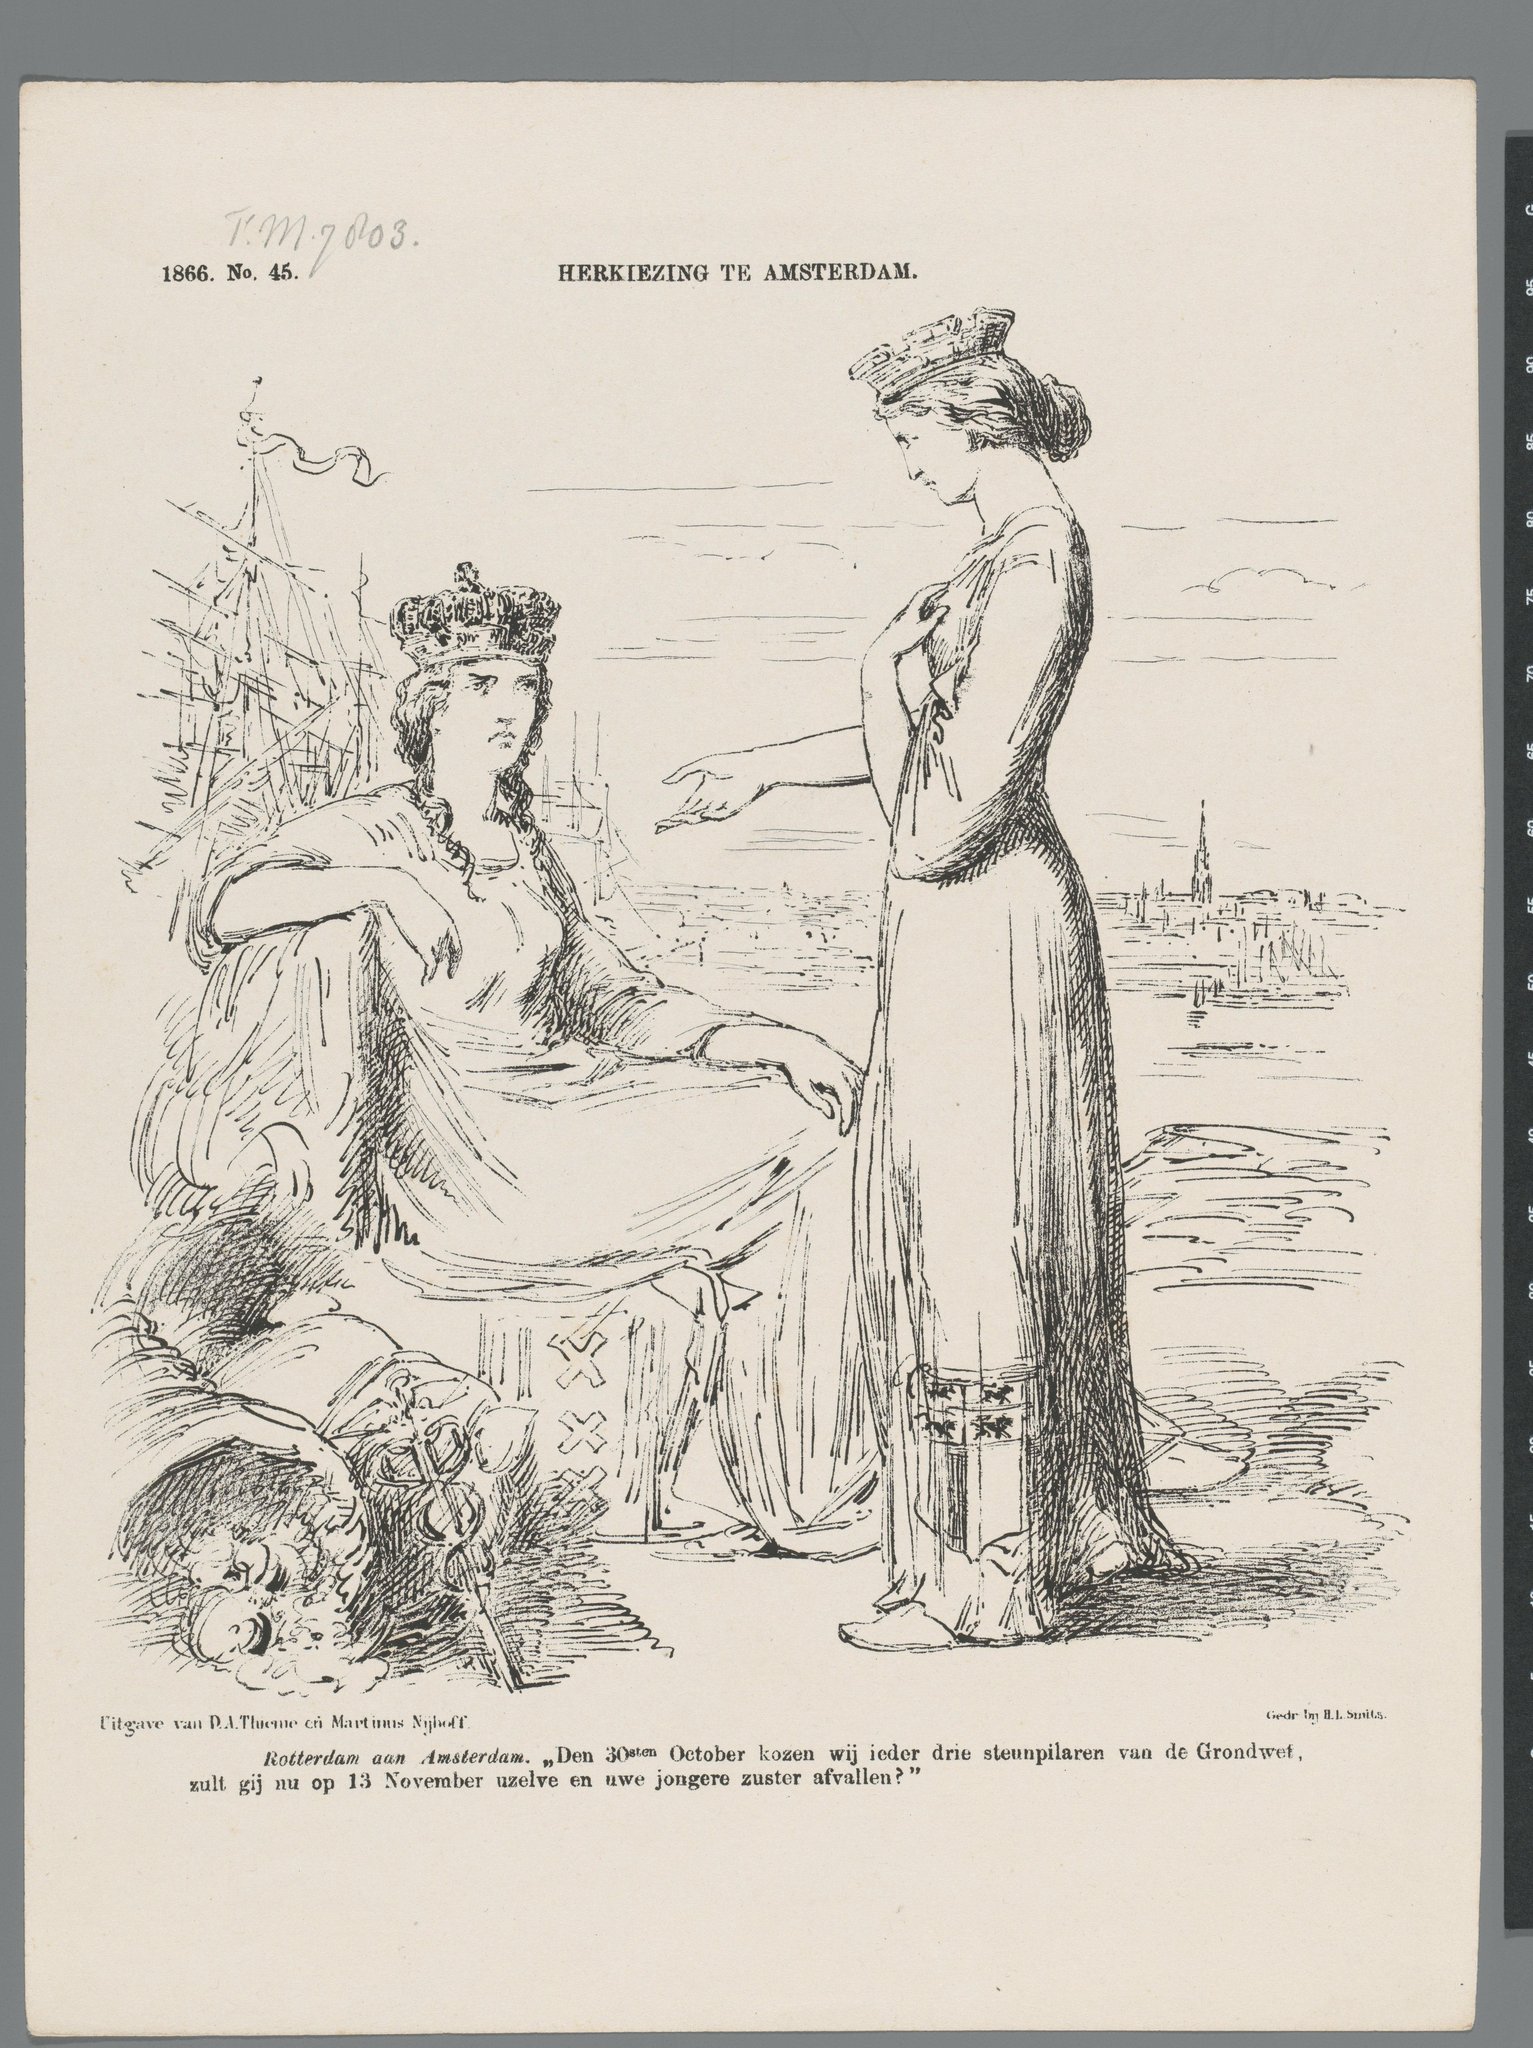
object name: cartoon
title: Herkiezing te Amsterdam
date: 1866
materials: paper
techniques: lithograph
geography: arnhem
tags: personification of a city, town-patron(ess), rotterdam, amsterdam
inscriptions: collector's mark: Lugt 2228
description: Spotprent op de oproep tot herkiezing van de liberale vertegenwoordigers. De stedenmaagd van Rotterdam roept de de stedenmaagd van Amsterdam aan om de drie liberale kamerleden te herkiezen. Plaat verschenen bij het weekblad De Nederlandsche Spectator, nr. 45, 10 november 1866.